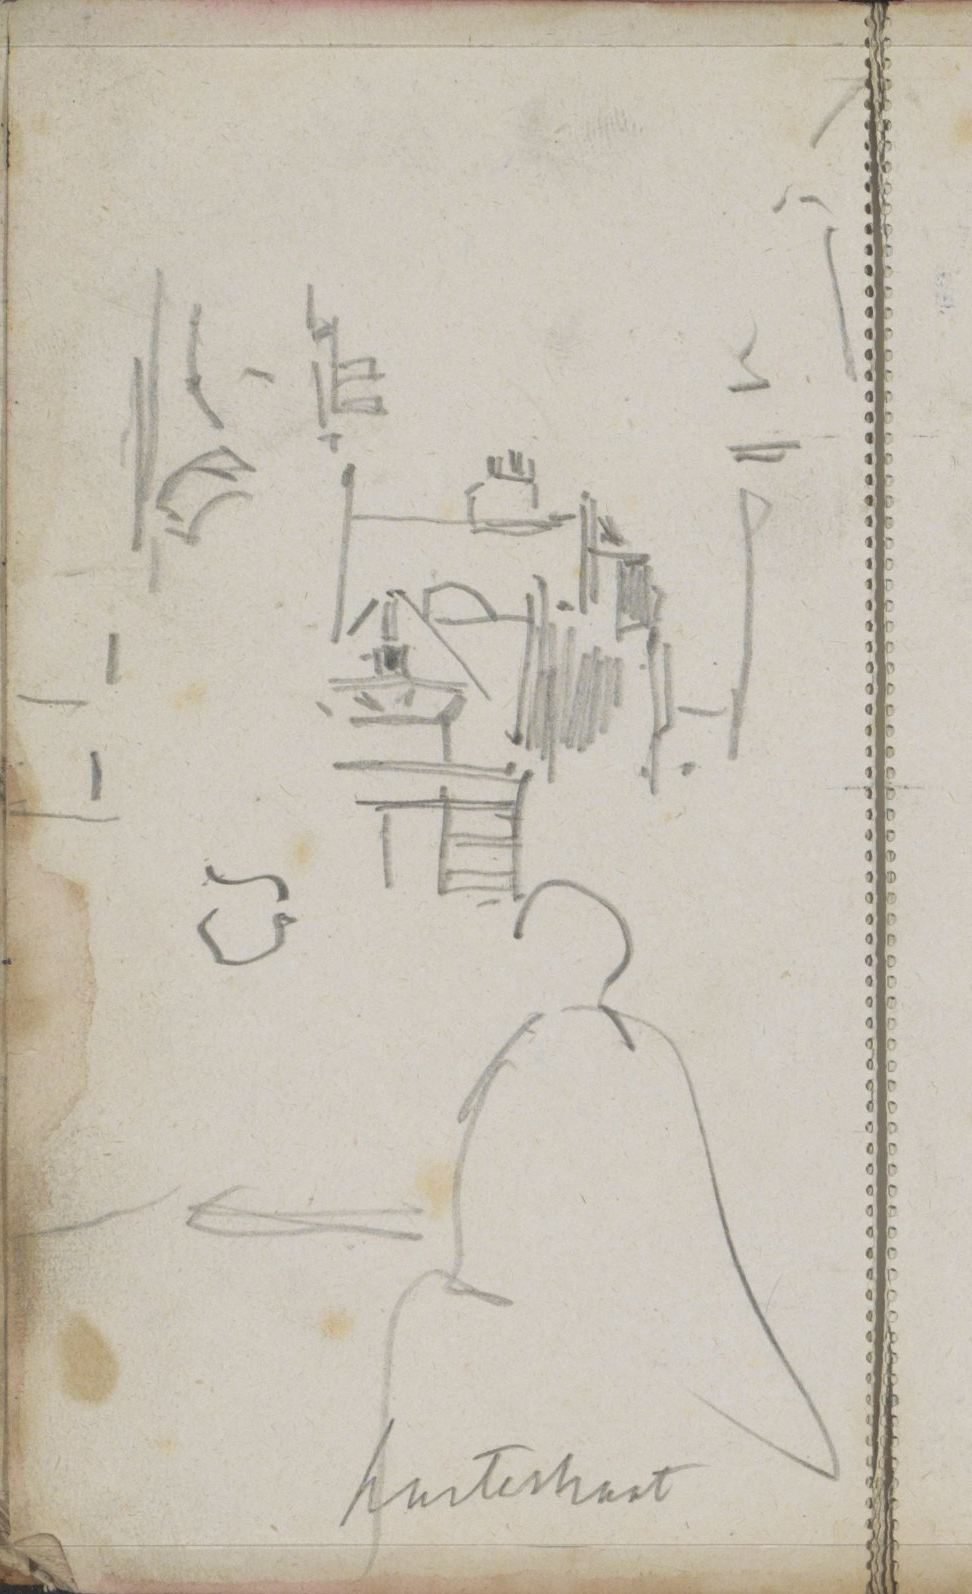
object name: sketchbook leaf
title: Gezicht op de Hartenstraat te Amsterdam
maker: george hendrik breitner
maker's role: draughtsman, painter, print maker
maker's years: 1857-1923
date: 1893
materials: paper, pencil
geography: amsterdam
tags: adult woman, street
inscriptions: annotation: ‘Hartestraat [sic]’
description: Gezicht op de Hartenstraat te Amsterdam. Vooraan een vrouw. Pagina 31 uit een schetsboek met 22 bladen vervaardigd te Amsterdam.